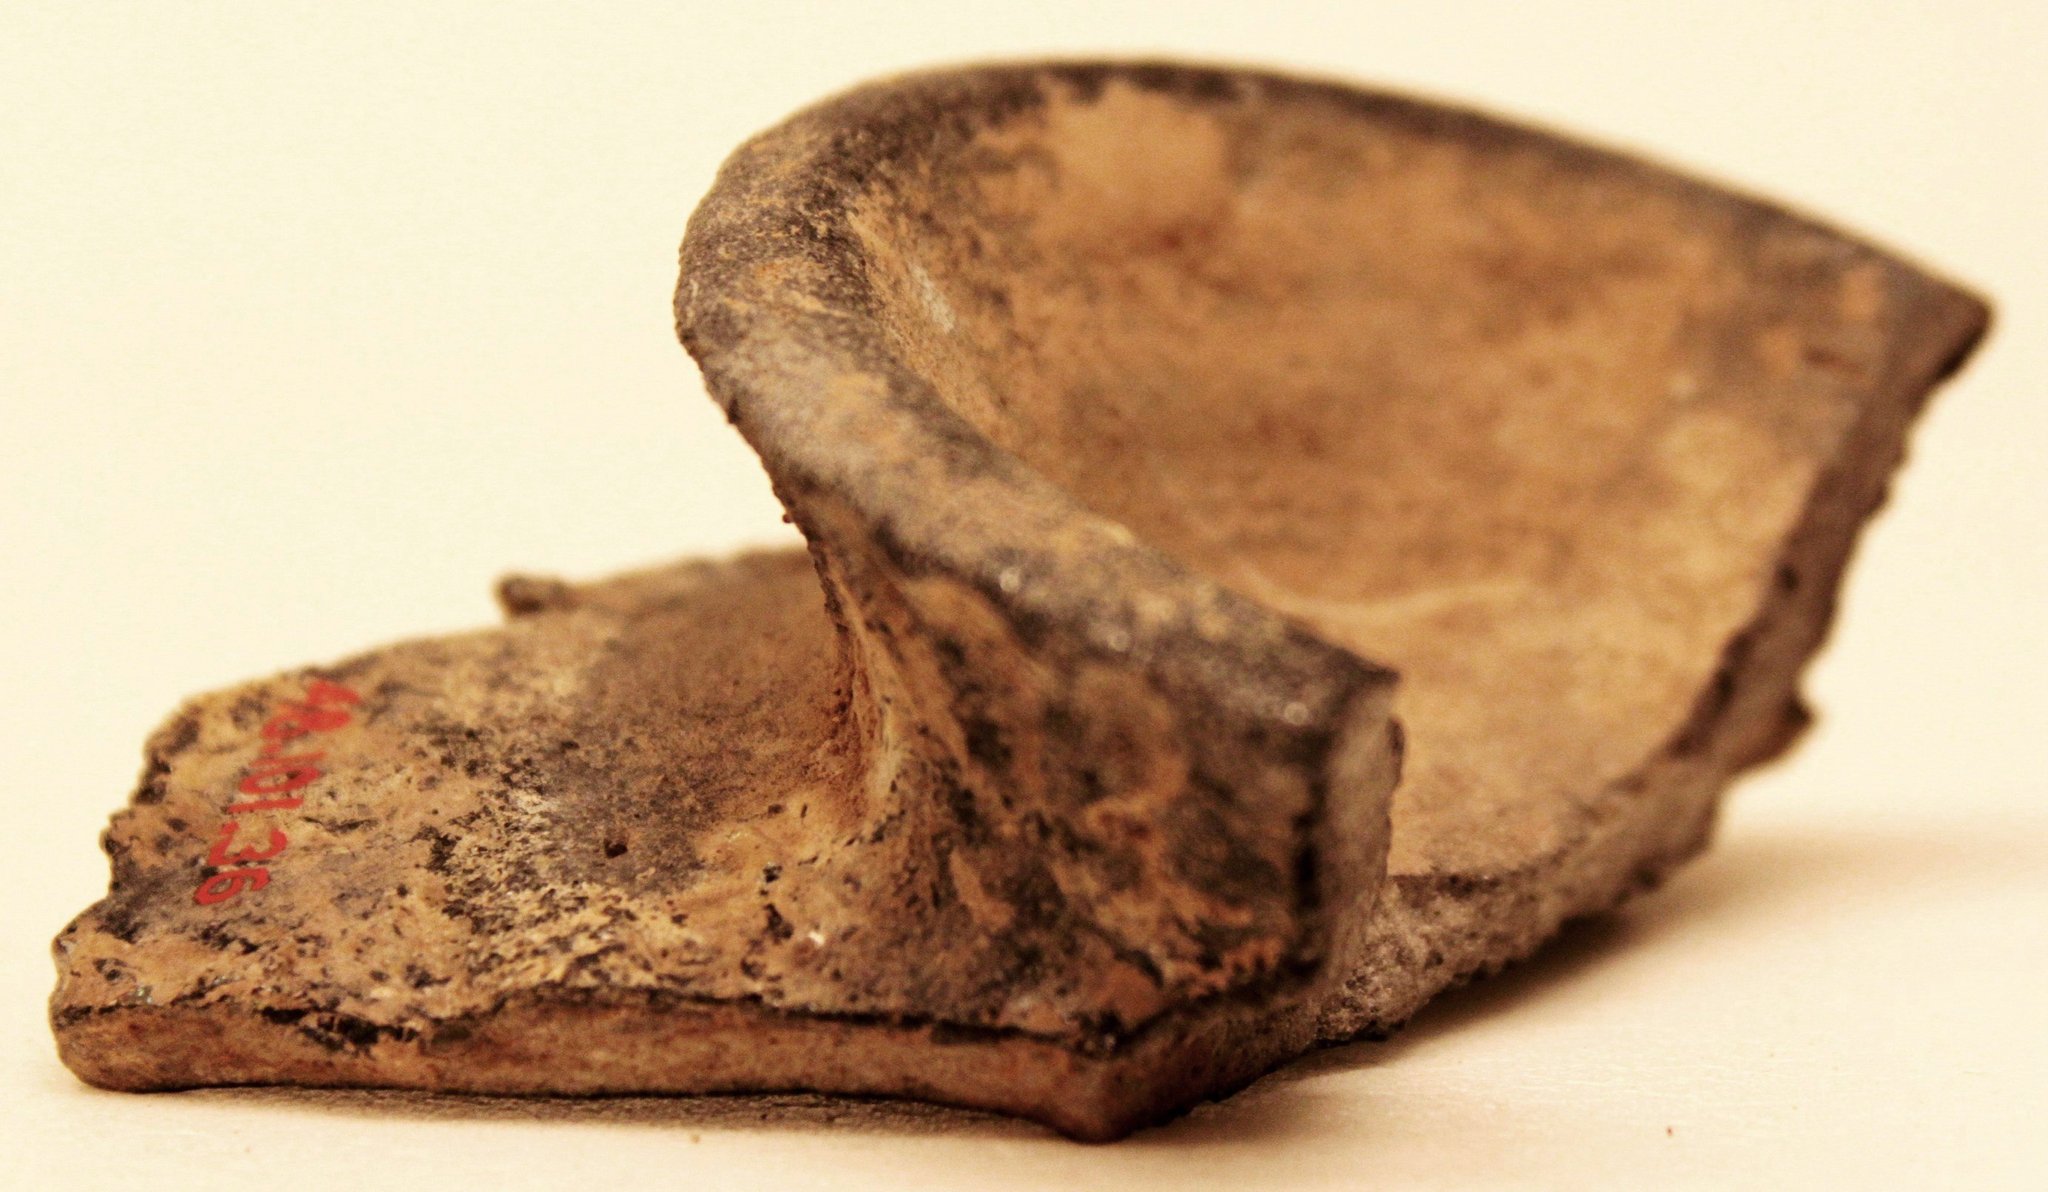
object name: fragment of a base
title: Fragment of a Misfired Vessel Base (Waster?)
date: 1001-1200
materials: charcoal, glaze, stonepaste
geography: iran